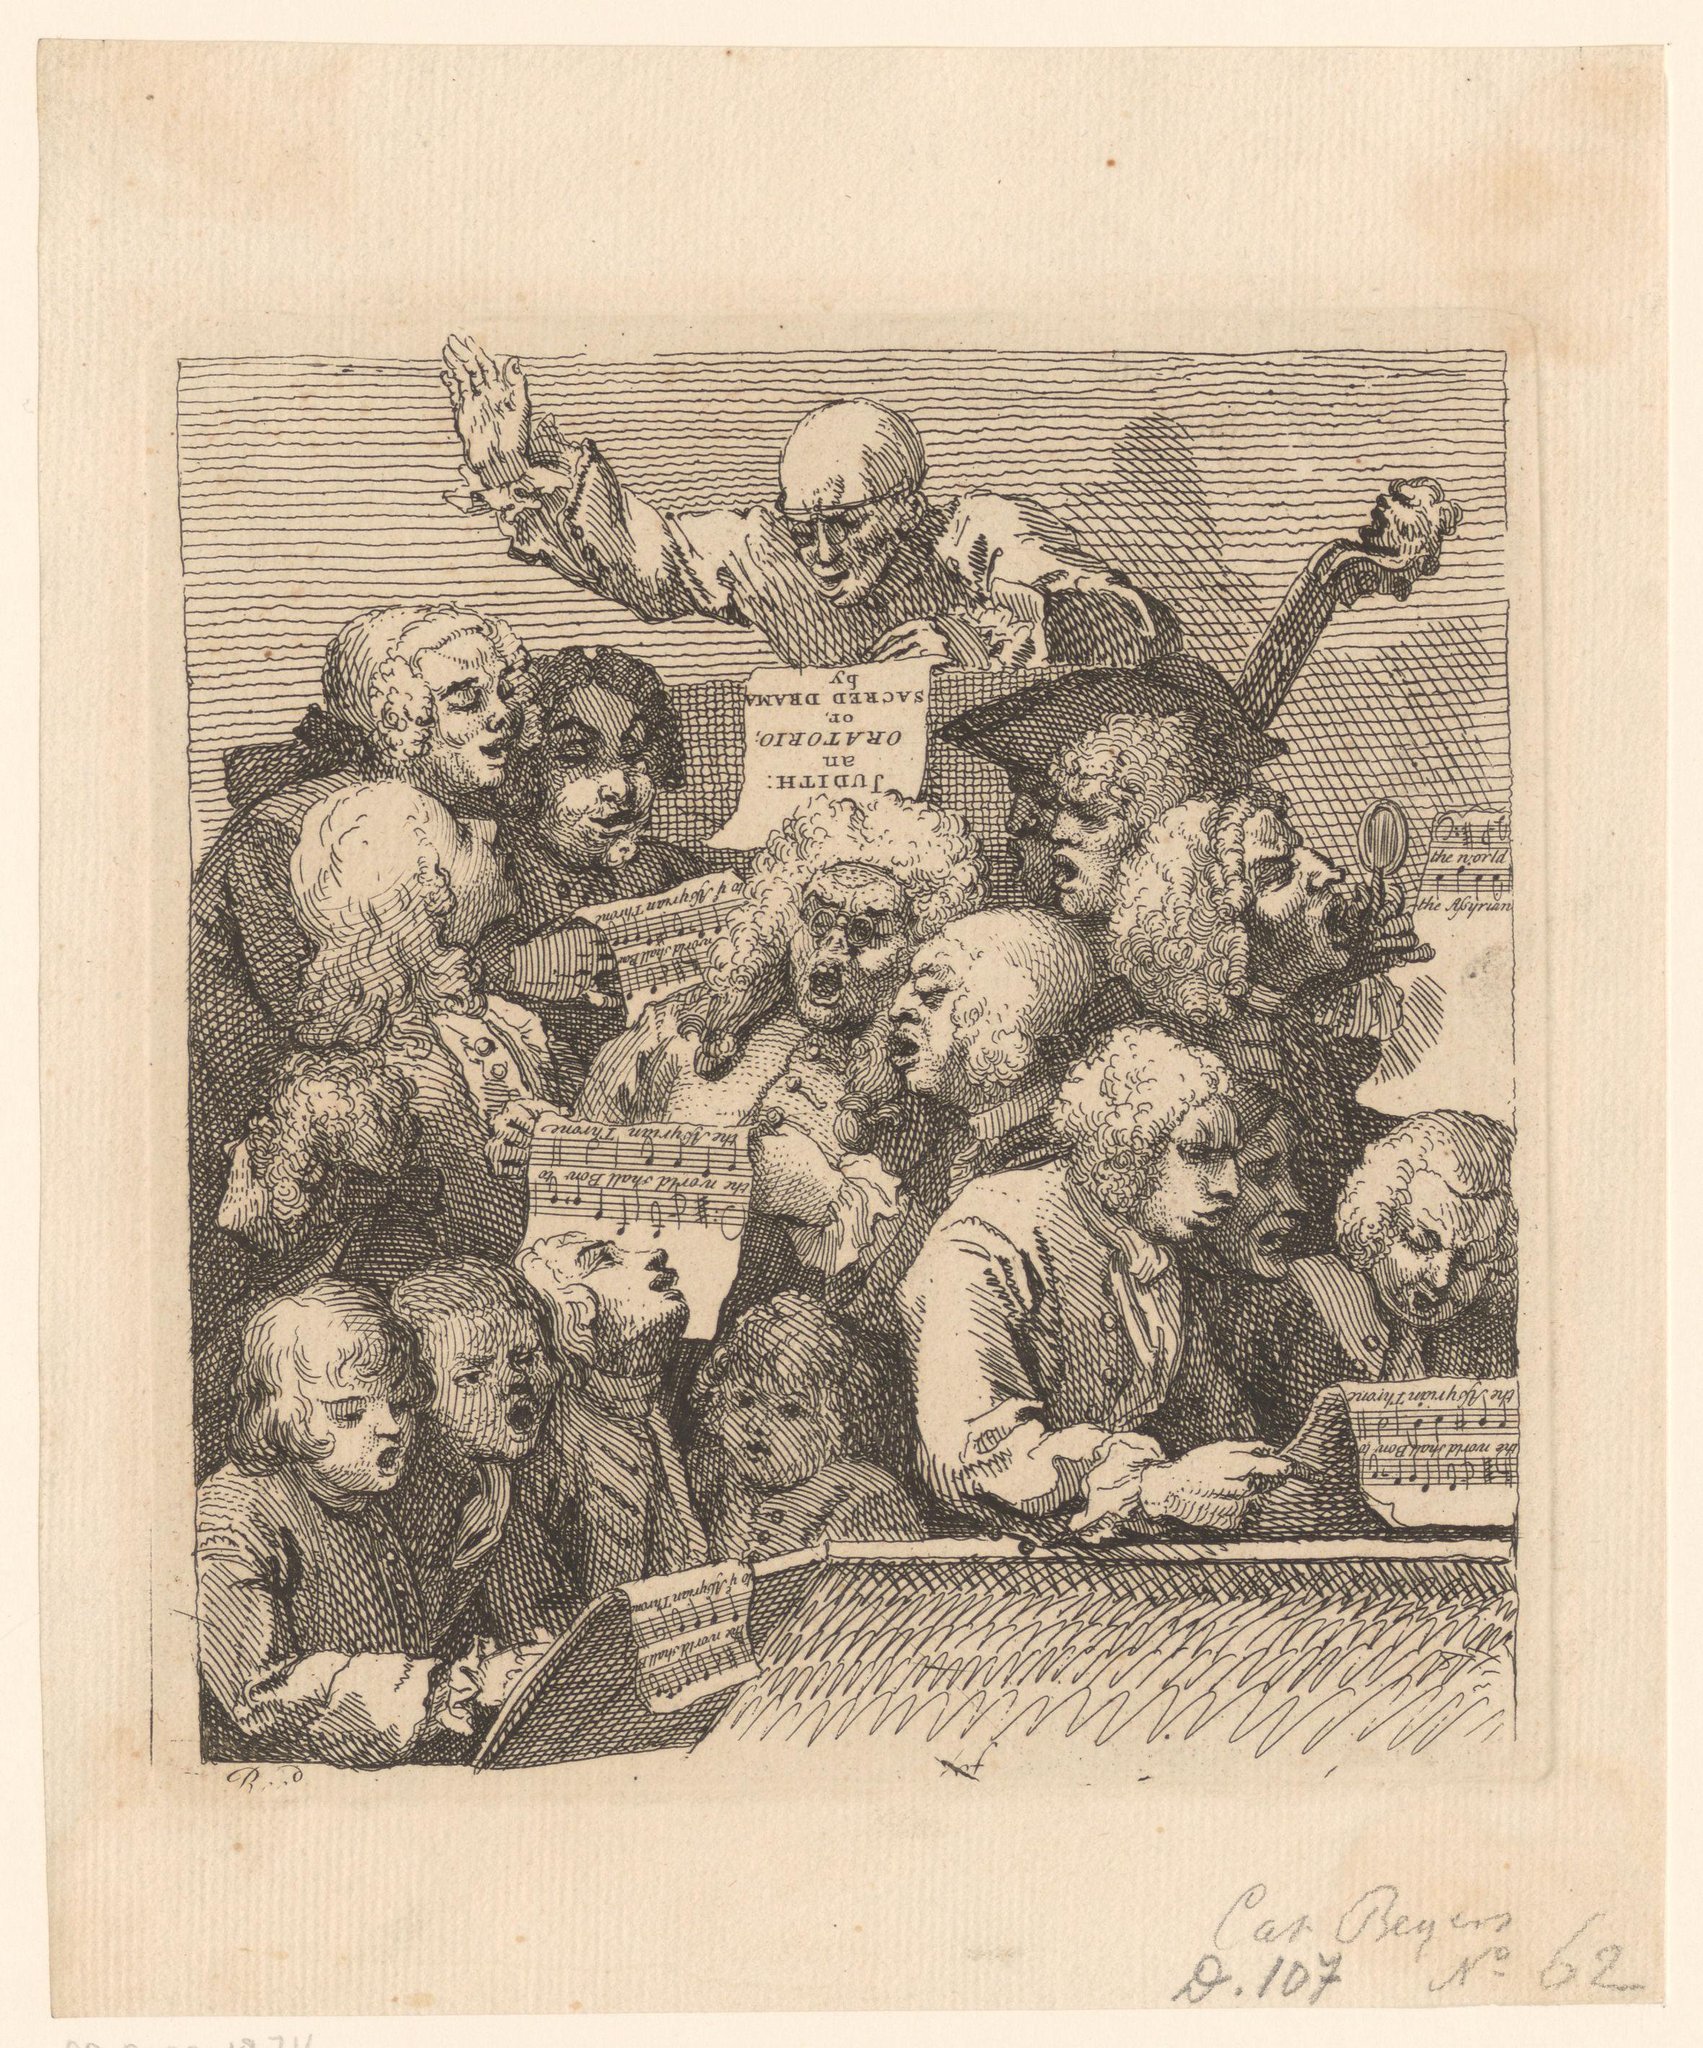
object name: print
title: Koor van zingende mannen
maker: william hogarth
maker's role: draughtsman, painter, print maker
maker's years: 1697-1764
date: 1707-1732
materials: paper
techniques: etching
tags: choir, political caricatures and satires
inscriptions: collector's mark: Lugt 2228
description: Tekst in het Engels op de papieren met bladmuziek. De heren repeteren 'Judith' door William Huggins met muziek door William Defesch dat werd uitgevoerd op 16 februari 1732.